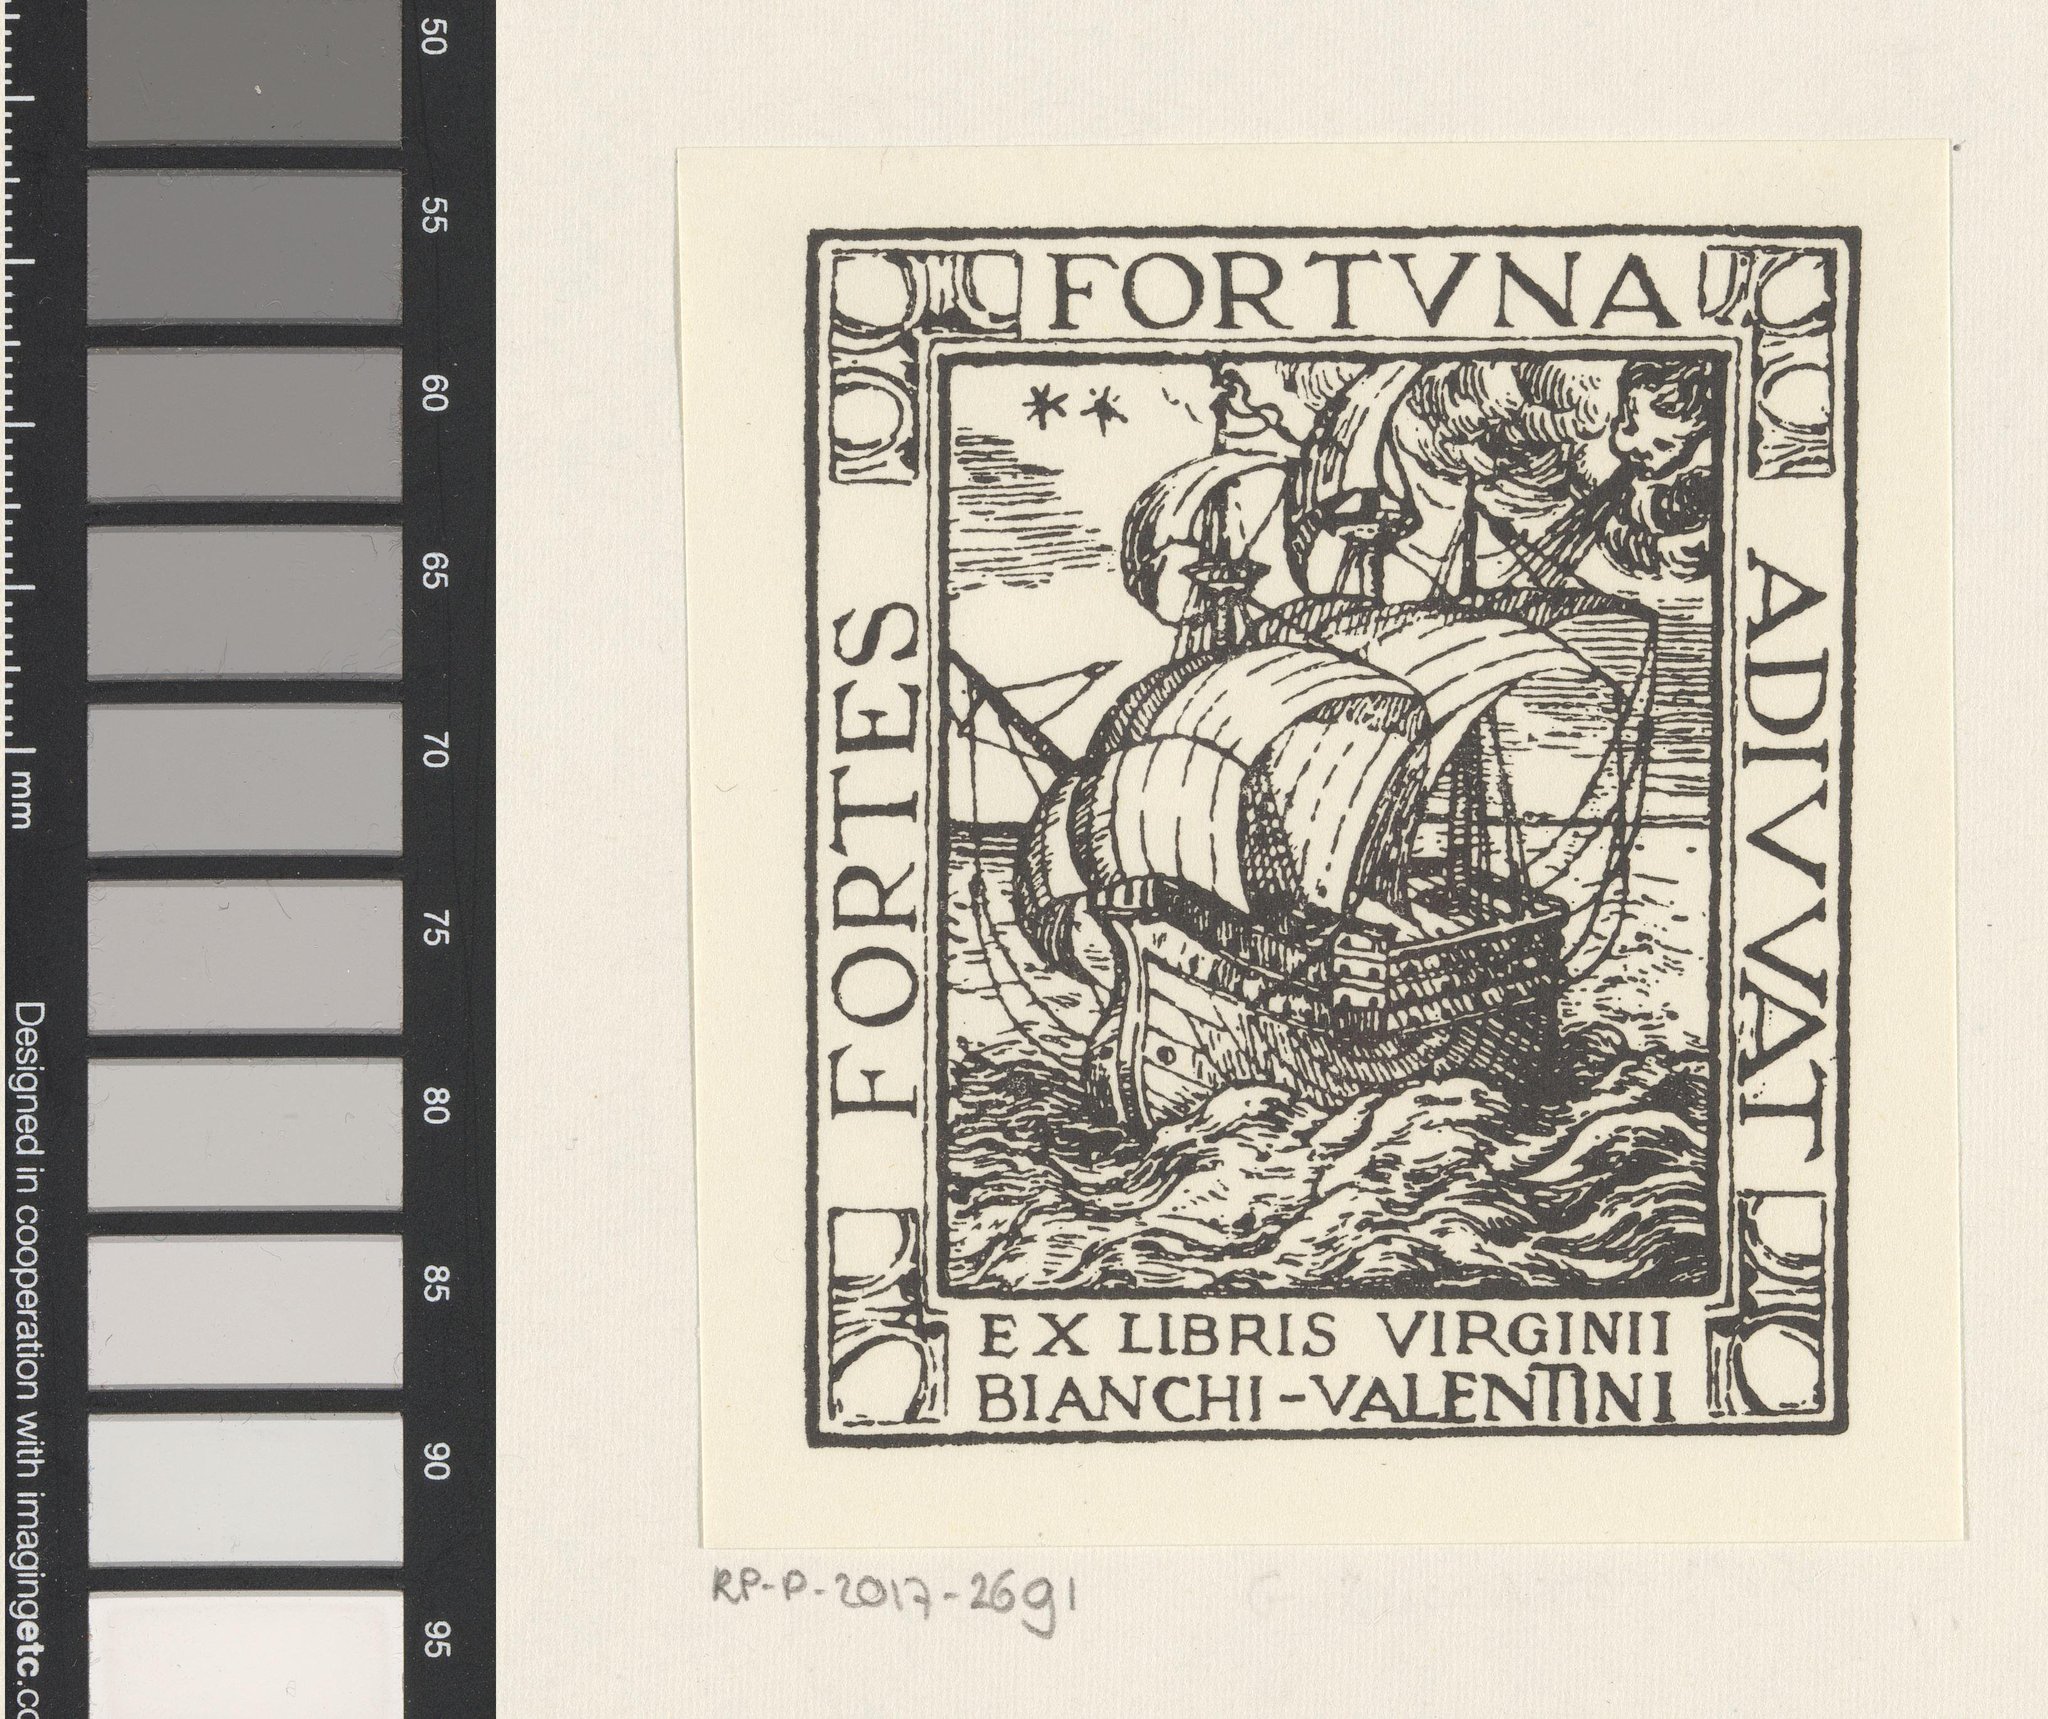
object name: bookplate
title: Ex libris Virginii Bianchi-Valentini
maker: Anonymous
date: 1932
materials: paper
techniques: printing block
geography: italy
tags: painter, sailing-ship, sailing-boat, winds, sea